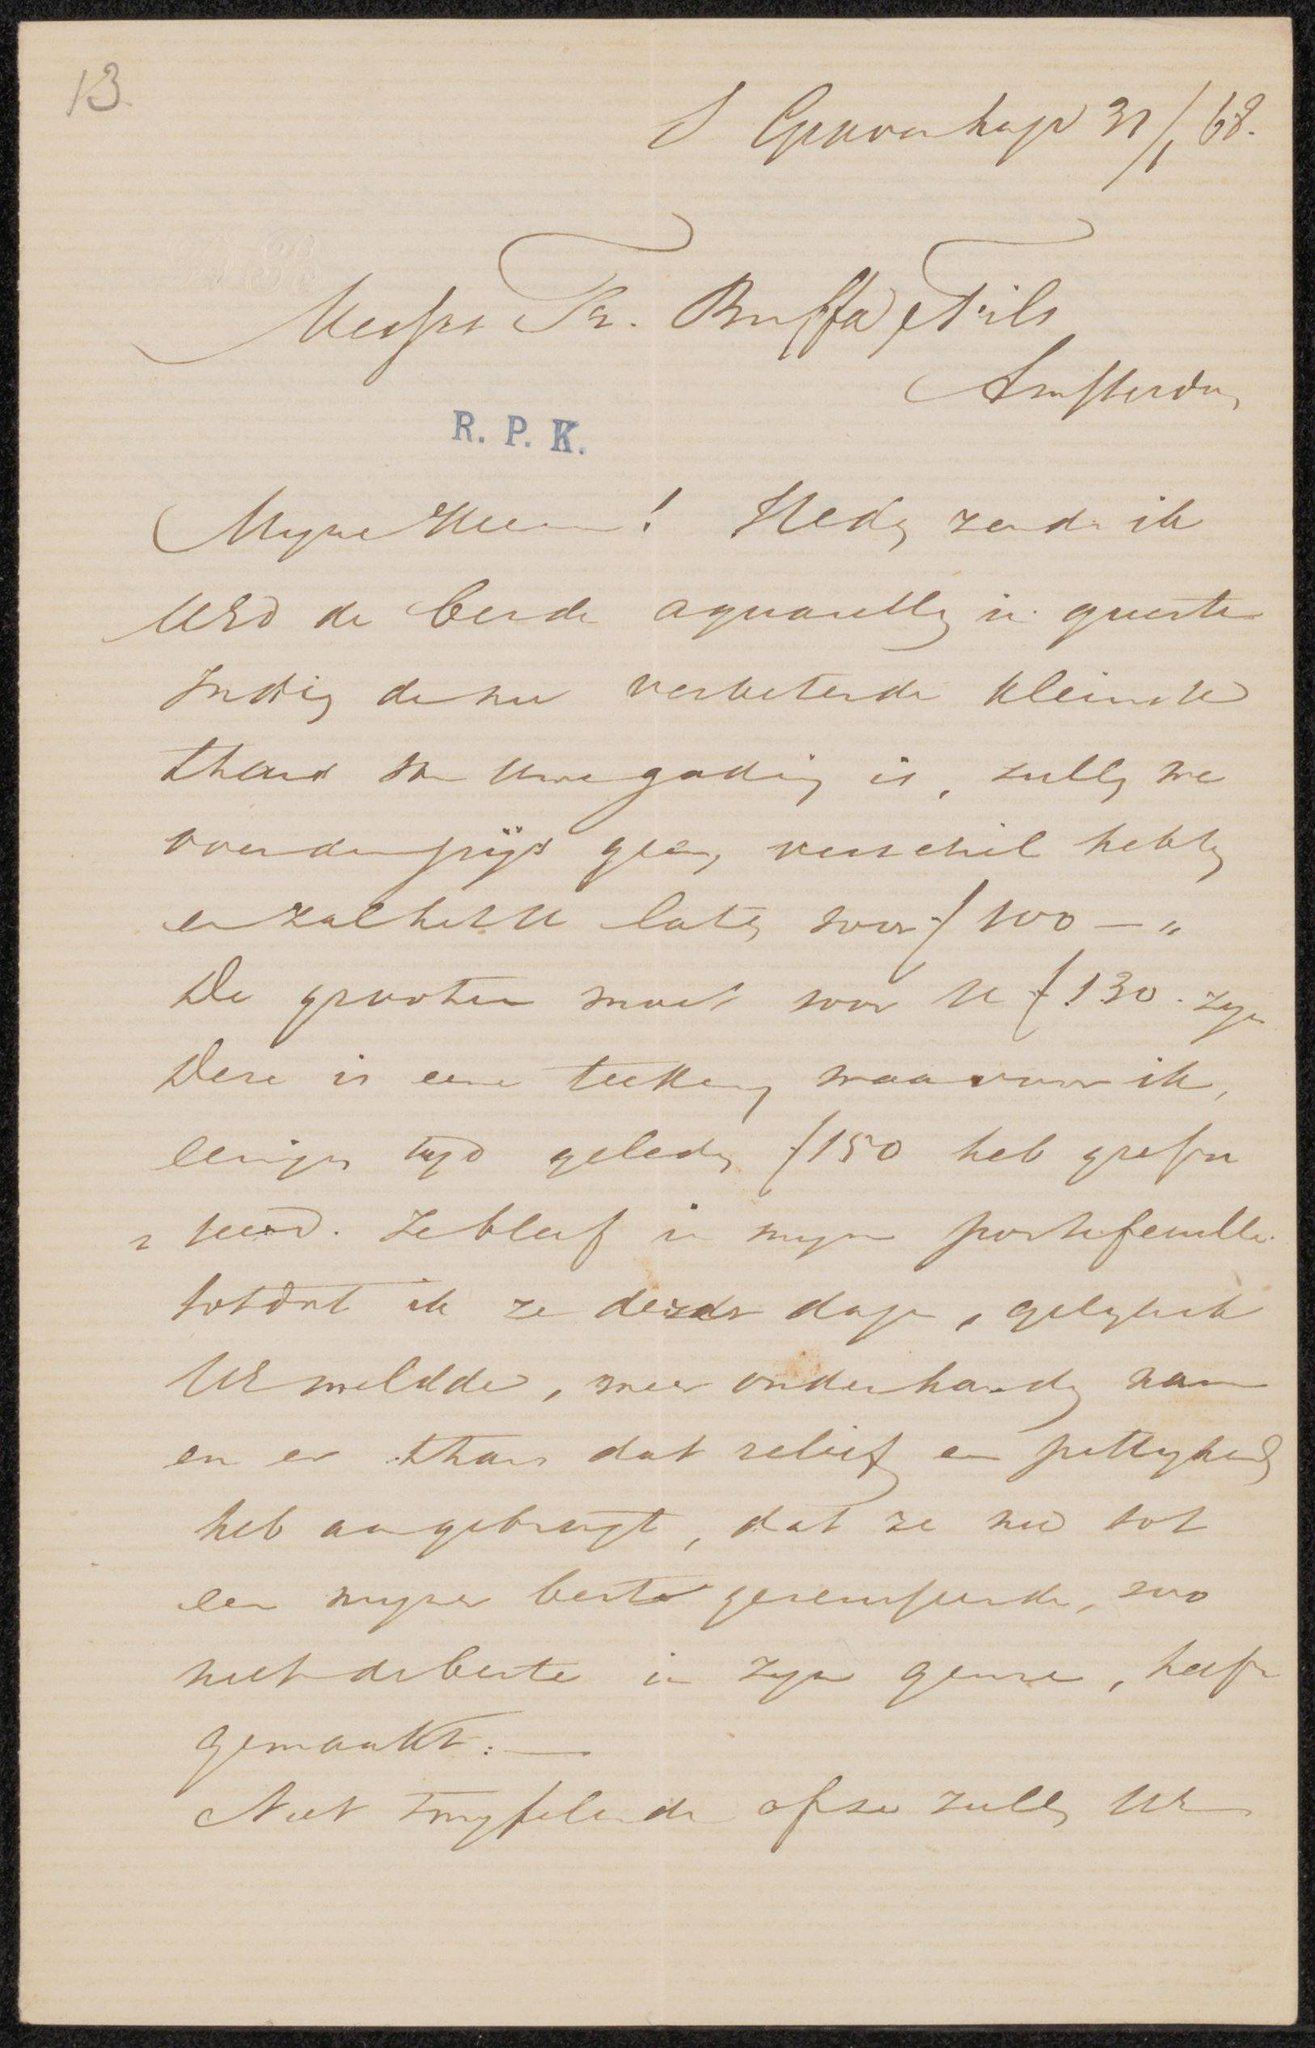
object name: letter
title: Brief aan Frans Buffa en Zonen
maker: david bles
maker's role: draughtsman, painter, print maker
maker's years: 1821-1899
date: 1868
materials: ink, paper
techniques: pen, writing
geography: the hague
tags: art trade, art shop, drawing, money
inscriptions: collector's mark: Lugt 2233, monogram: ‘DB’